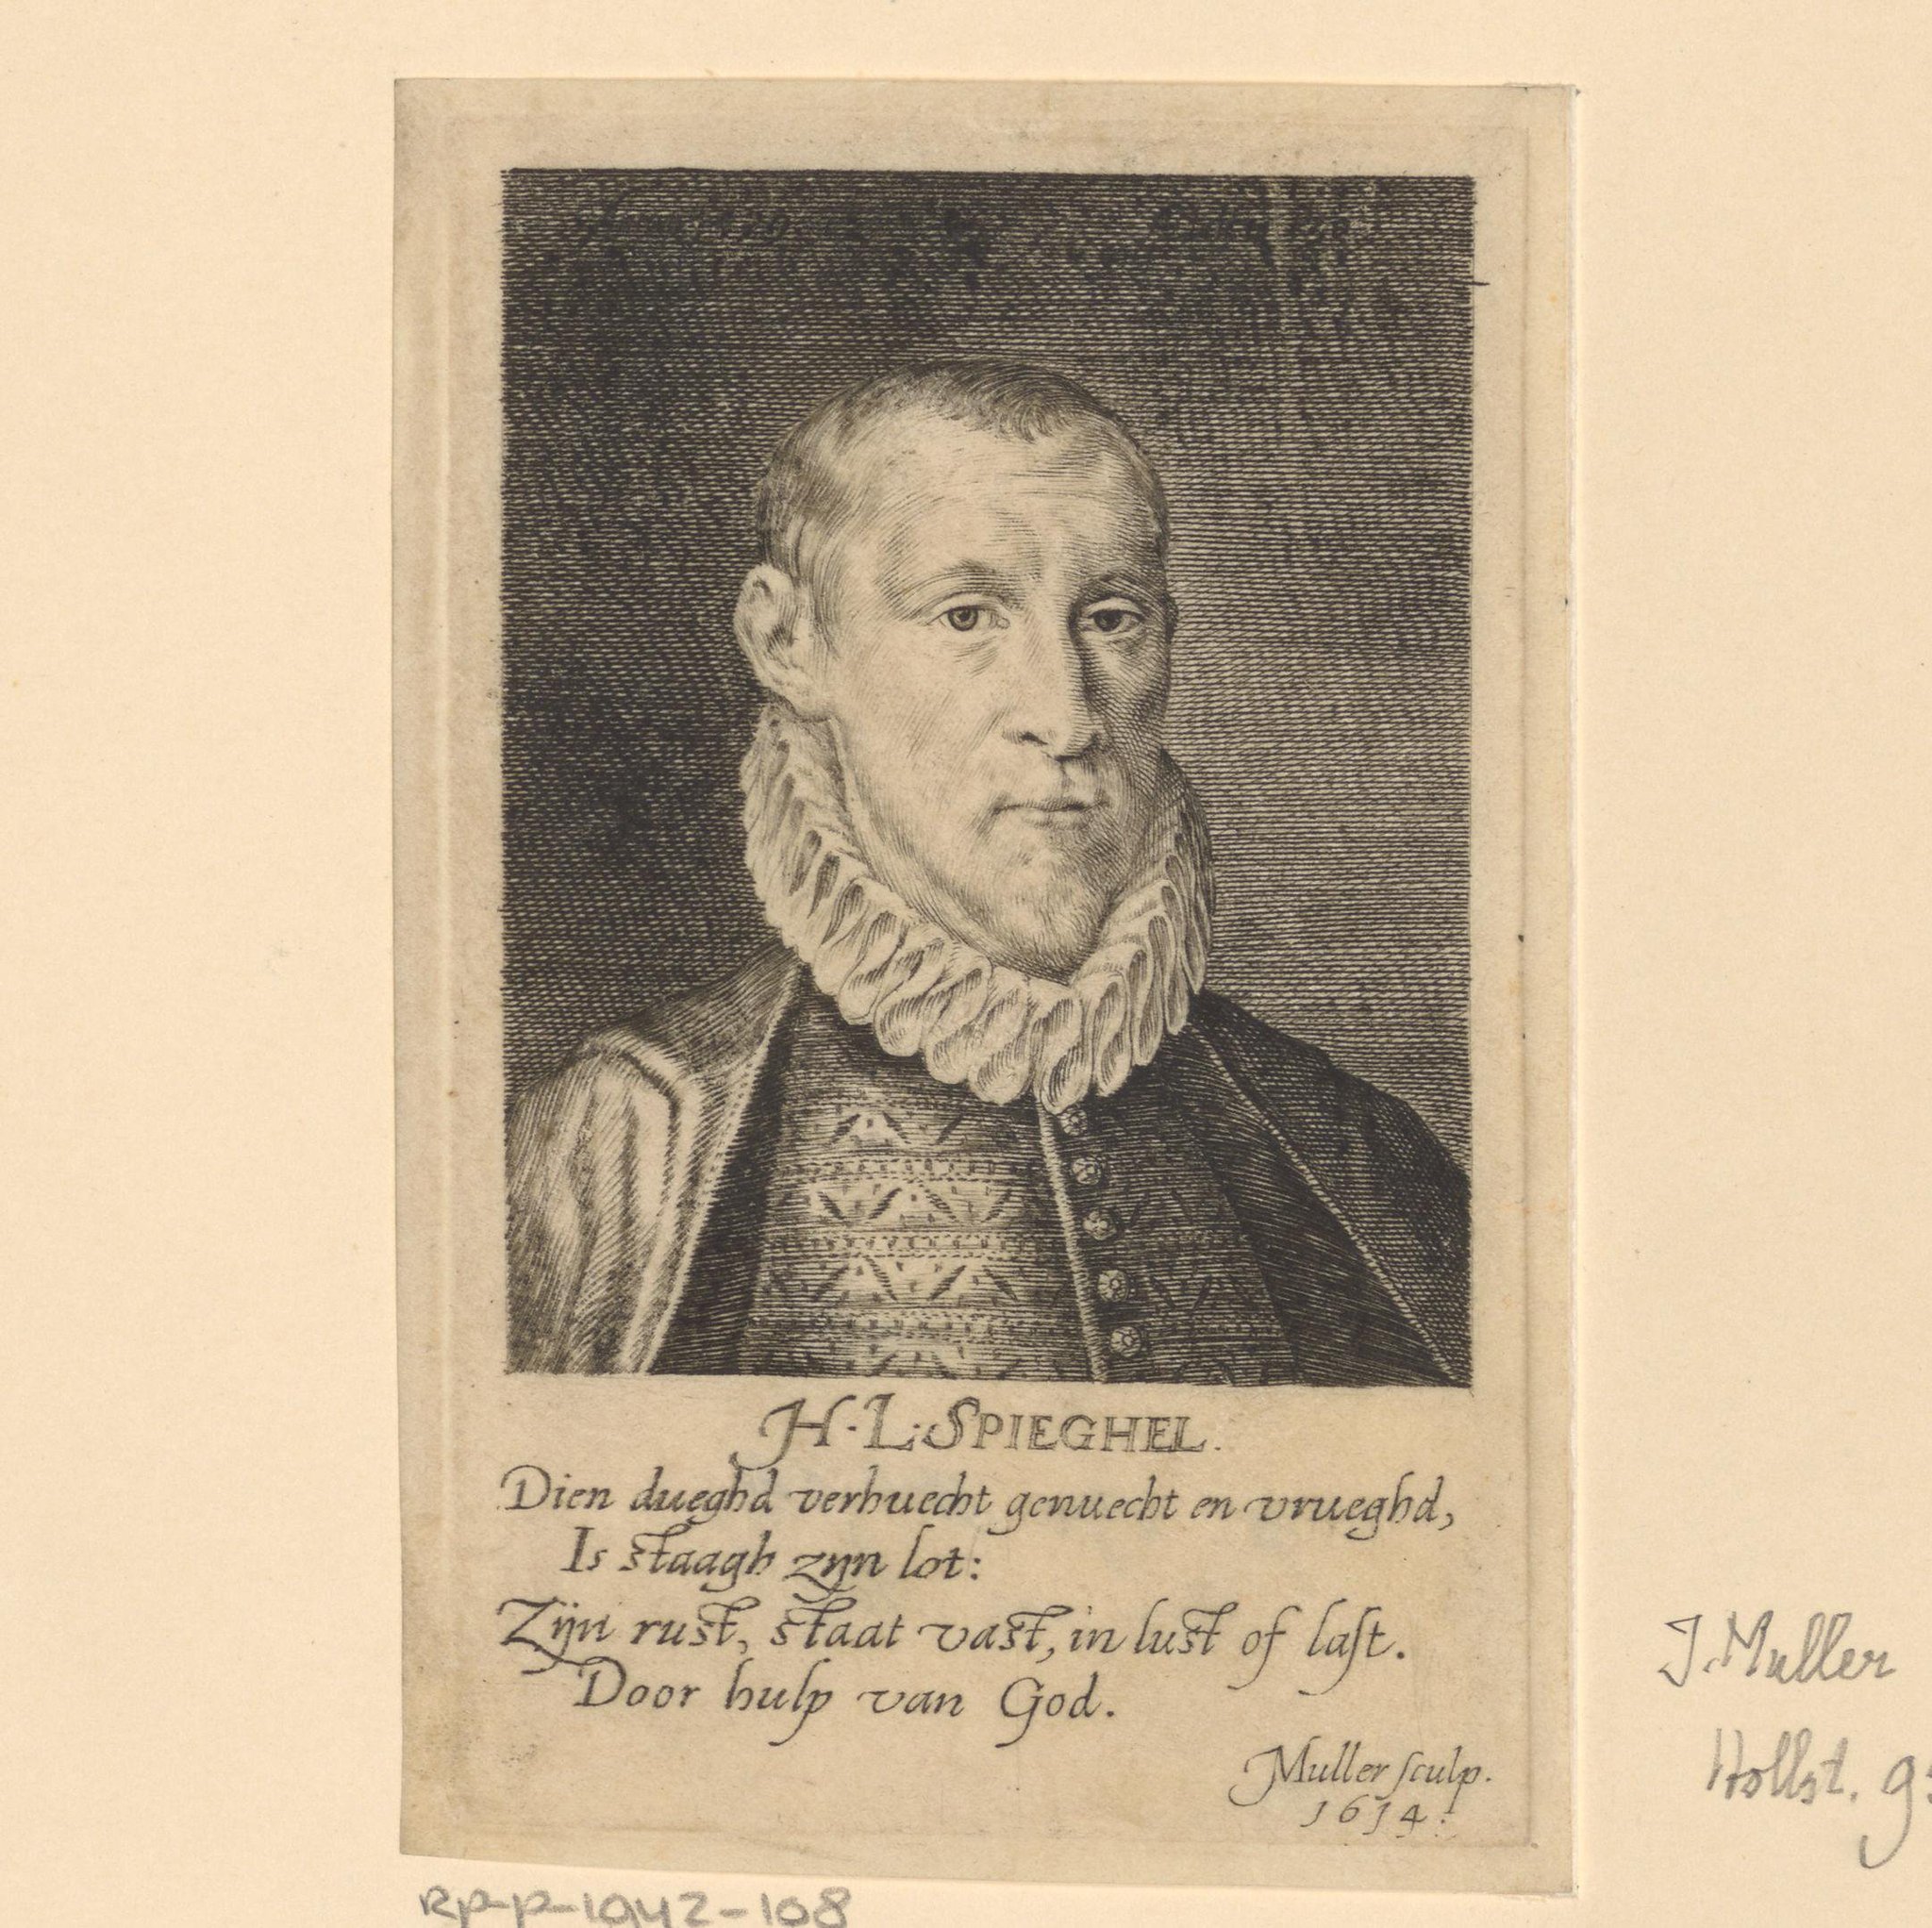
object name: print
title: Portret van Hendrick Laurensz. Spieghel op 30-jarige leeftijd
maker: jan harmensz. muller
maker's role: draughtsman, print maker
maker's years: 1571-1628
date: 1614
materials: parchment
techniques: engraving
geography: amsterdam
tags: amsterdam, hendrick laurensz. spieghel, historical persons, portrait of a writer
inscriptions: collector's mark: Lugt 2760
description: Prent met tekst in boekdruk gebruikt in: Spieghel, Hendrick Laurensz. Hart-spieghel. Amsterdam: Cornelis Dircksz Cool (I), 1615.